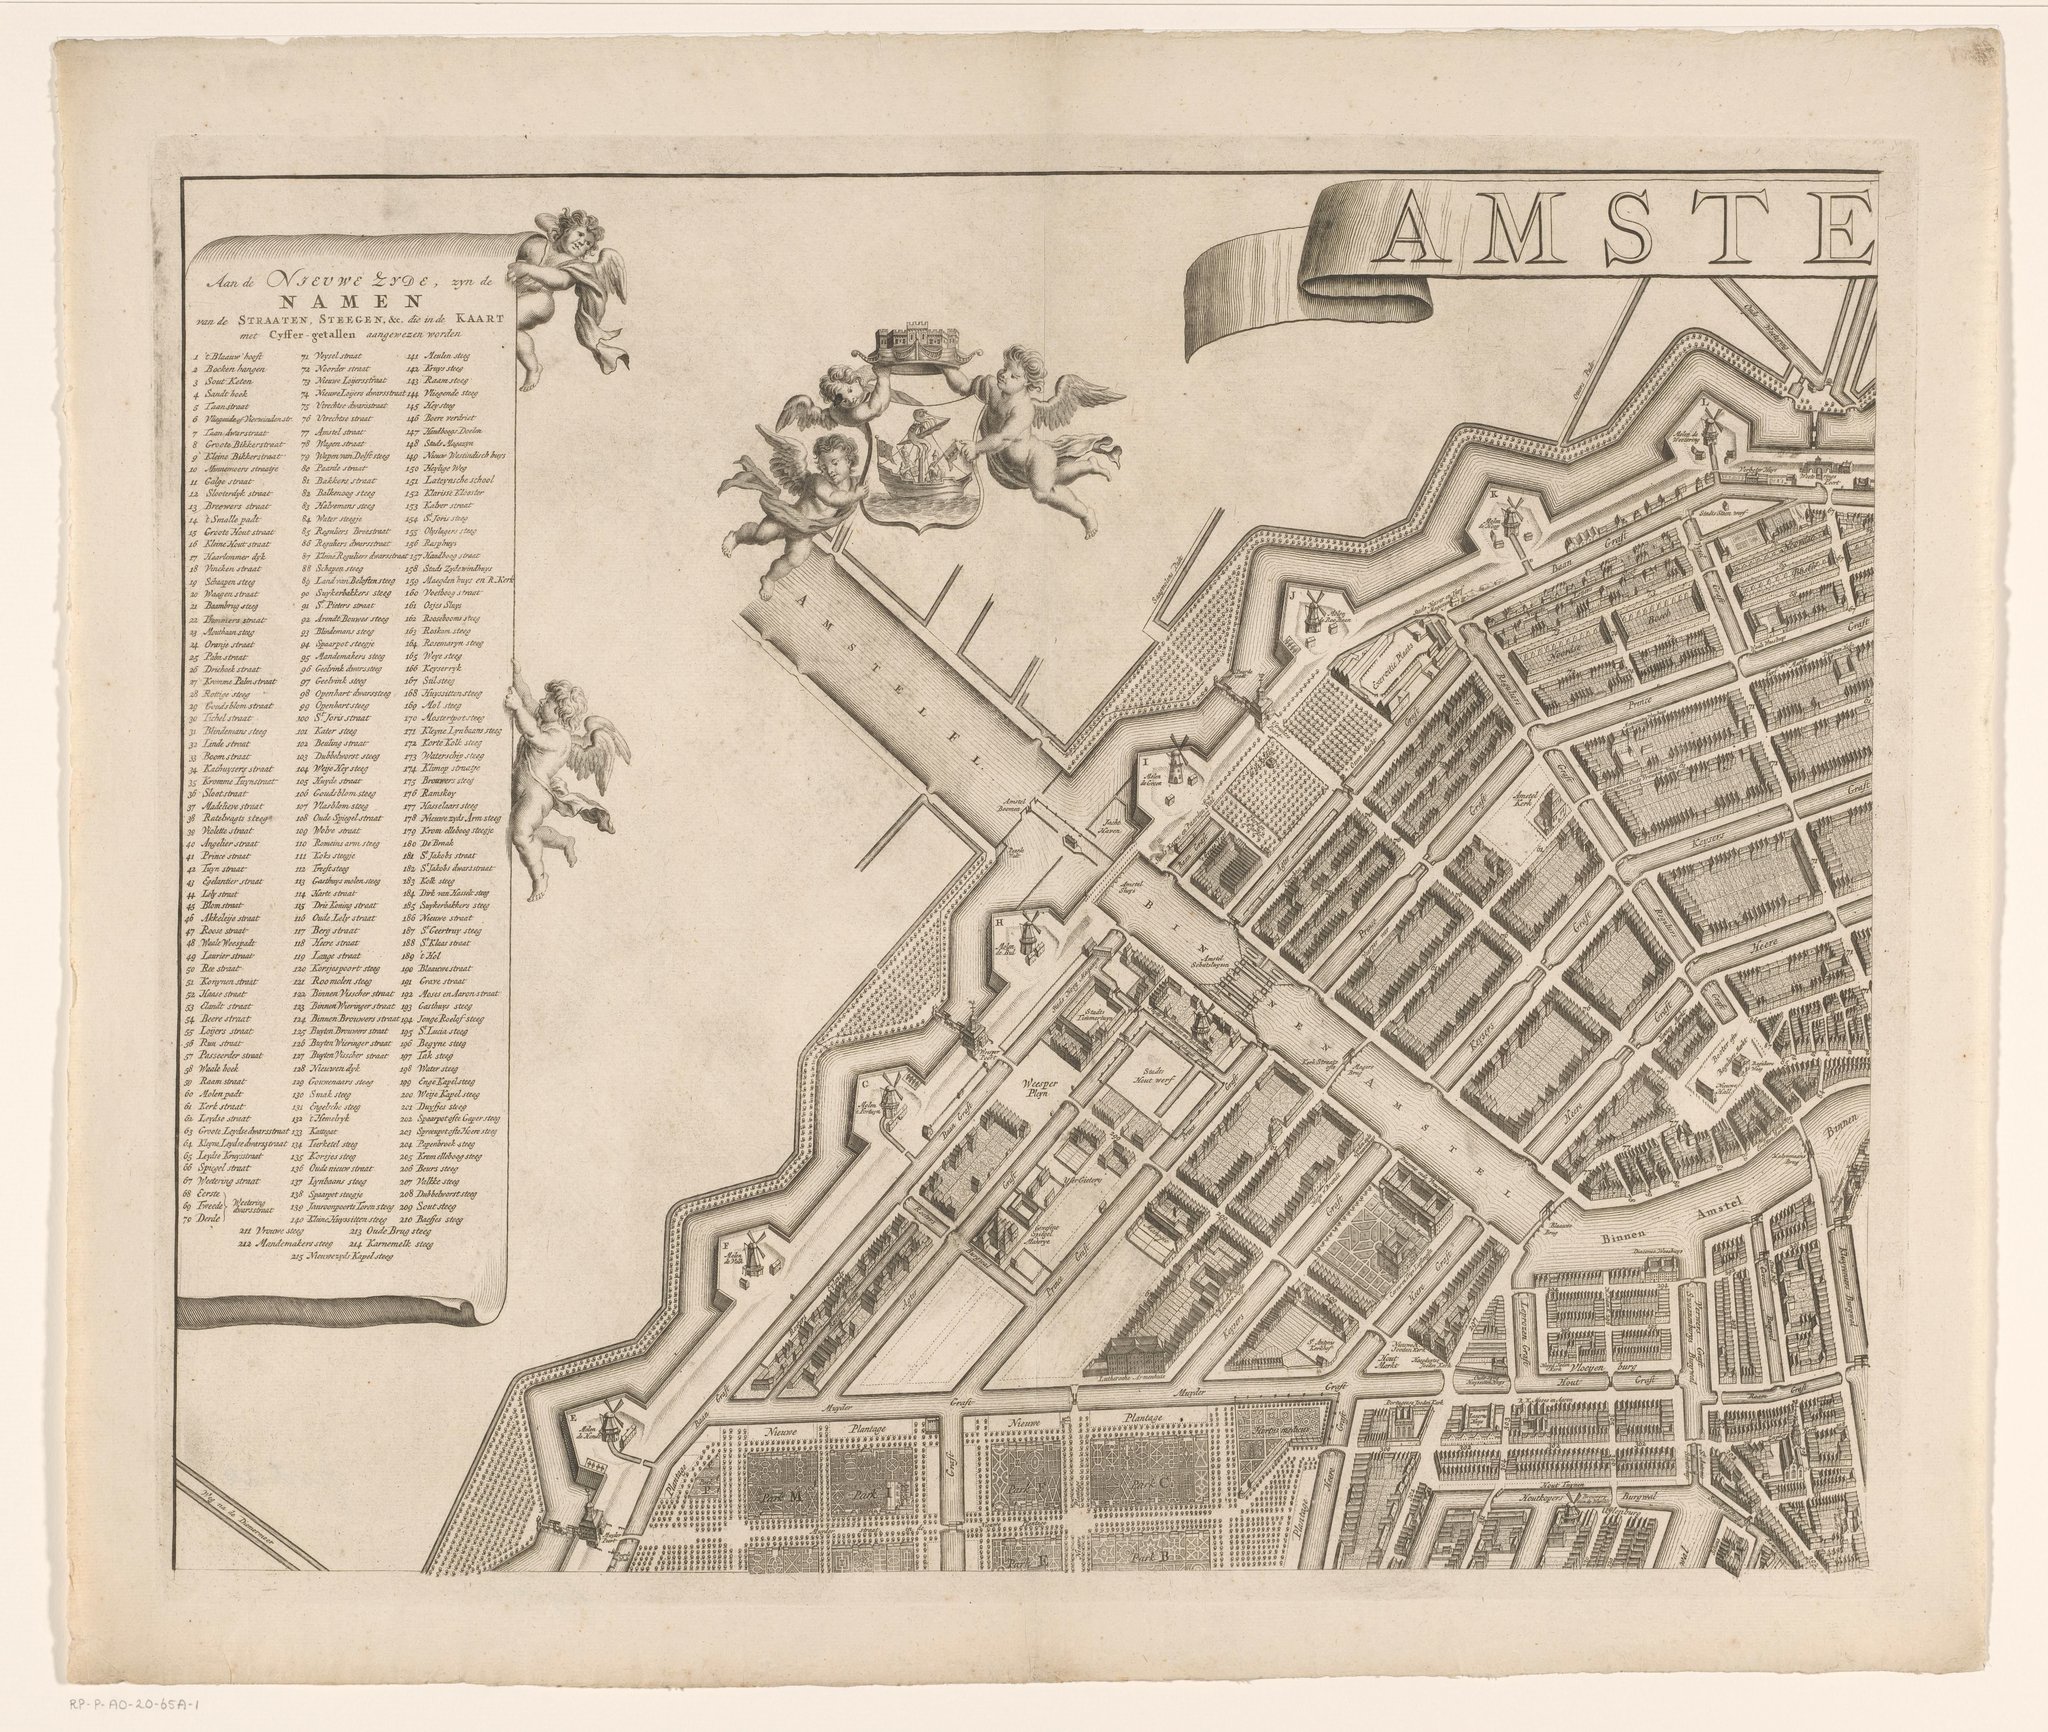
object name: area plan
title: Plattegrond van Amsterdam (deel linksboven)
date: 1724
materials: paper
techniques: engraving, etching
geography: amsterdam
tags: seal (as symbol of the state, etc.) (+ city; municipal), maps of cities, amsterdam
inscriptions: collector's mark: Lugt 2228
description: Deel (linksboven) van een plattegrond van Amsterdam, bestaande uit vier delen.